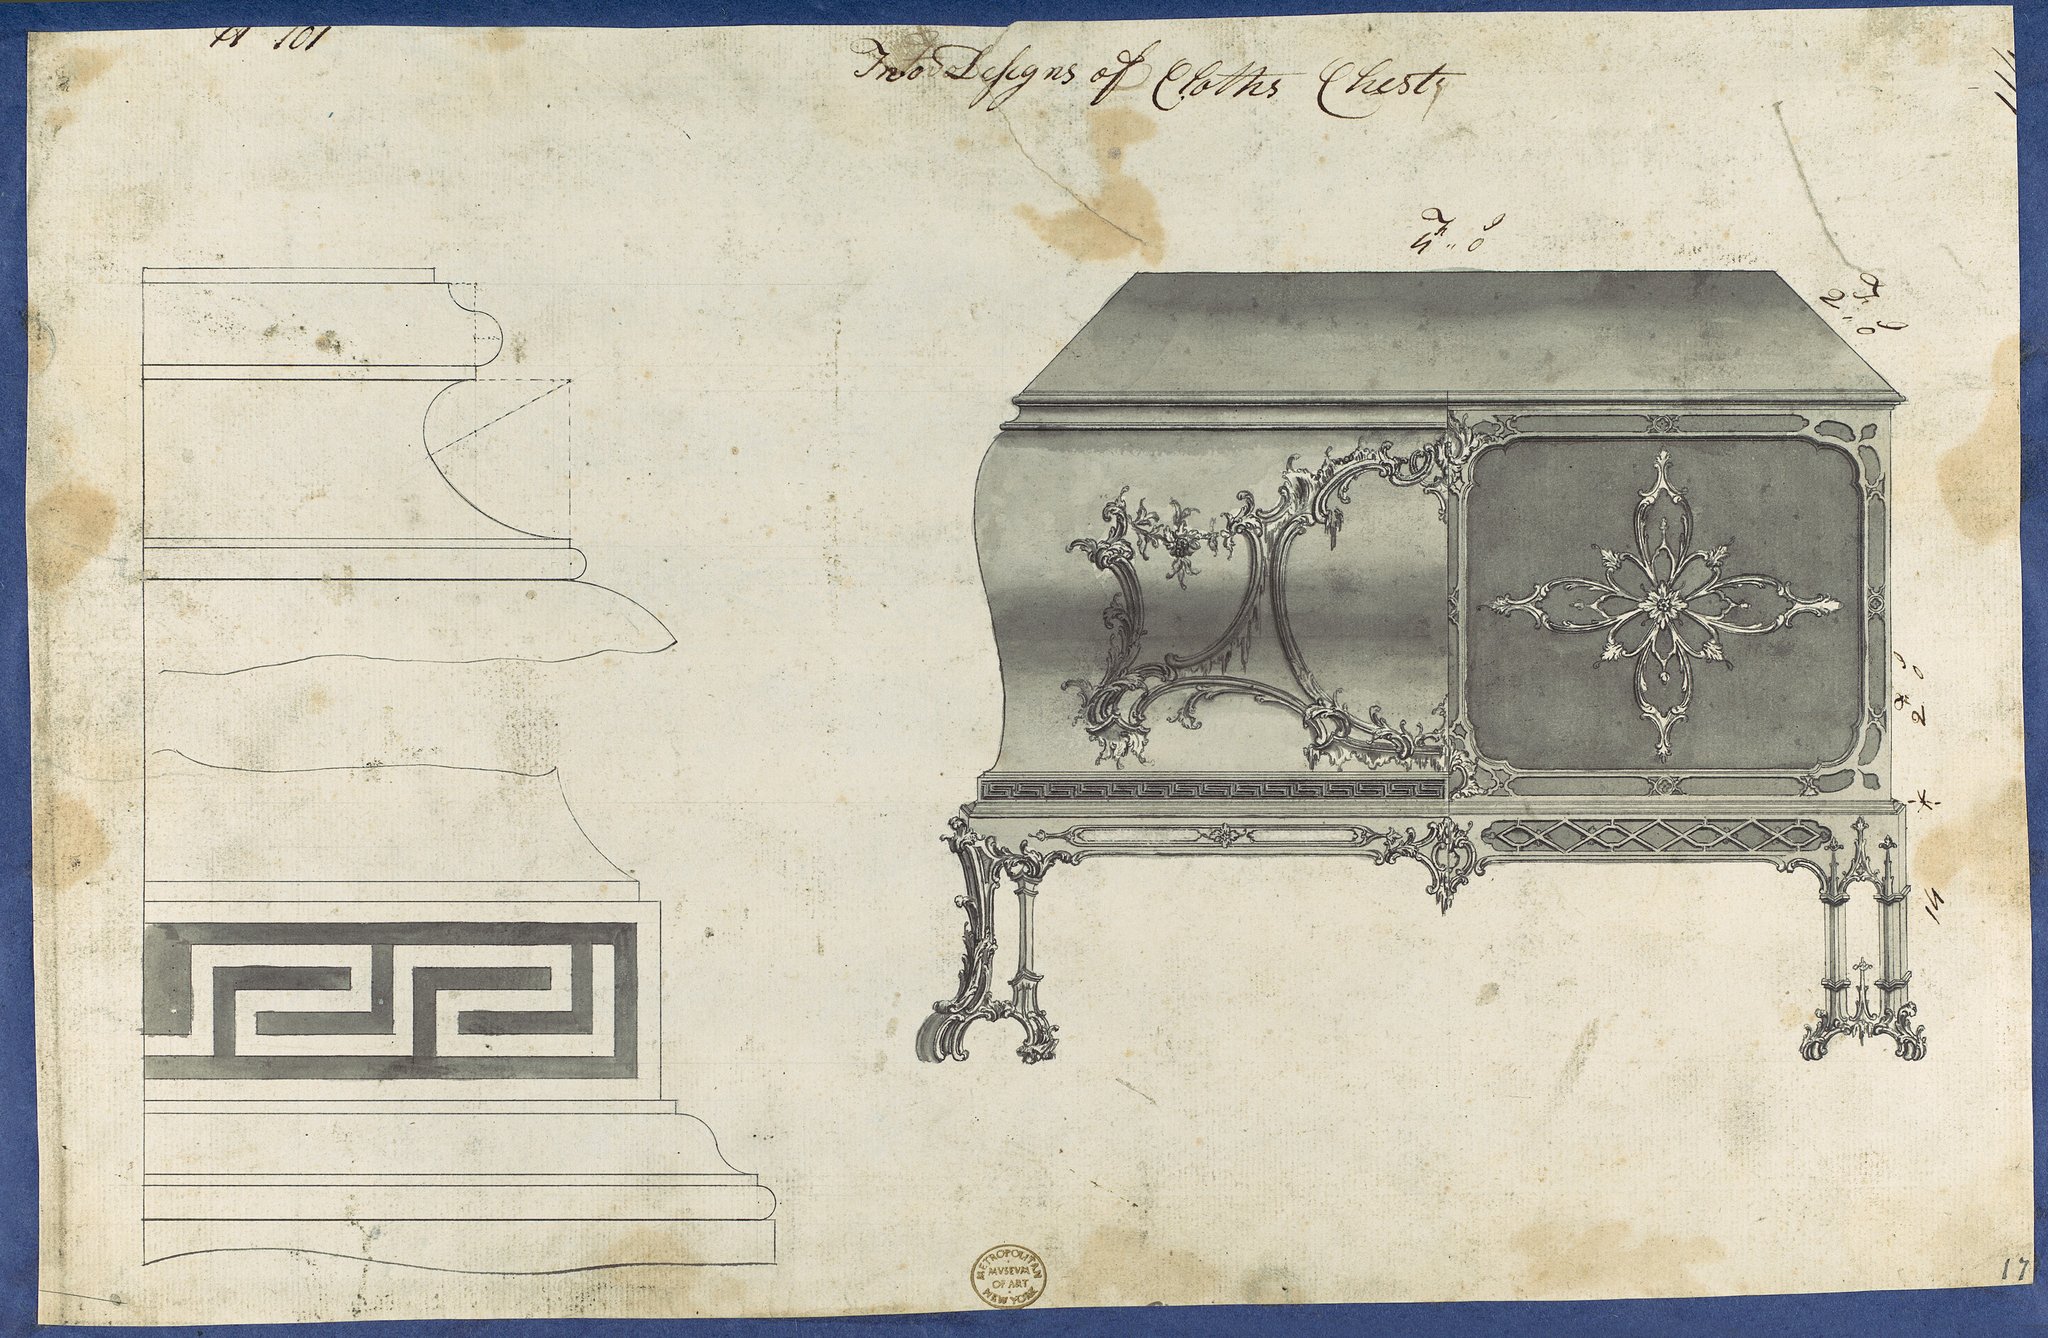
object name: drawing ornament architecture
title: Two Designs for Clothes Chest, from Chippendale Drawings, Vol. II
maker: thomas chippendale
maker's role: artist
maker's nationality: british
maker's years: 1718-1779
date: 1753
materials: ink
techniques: wash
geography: london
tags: chests